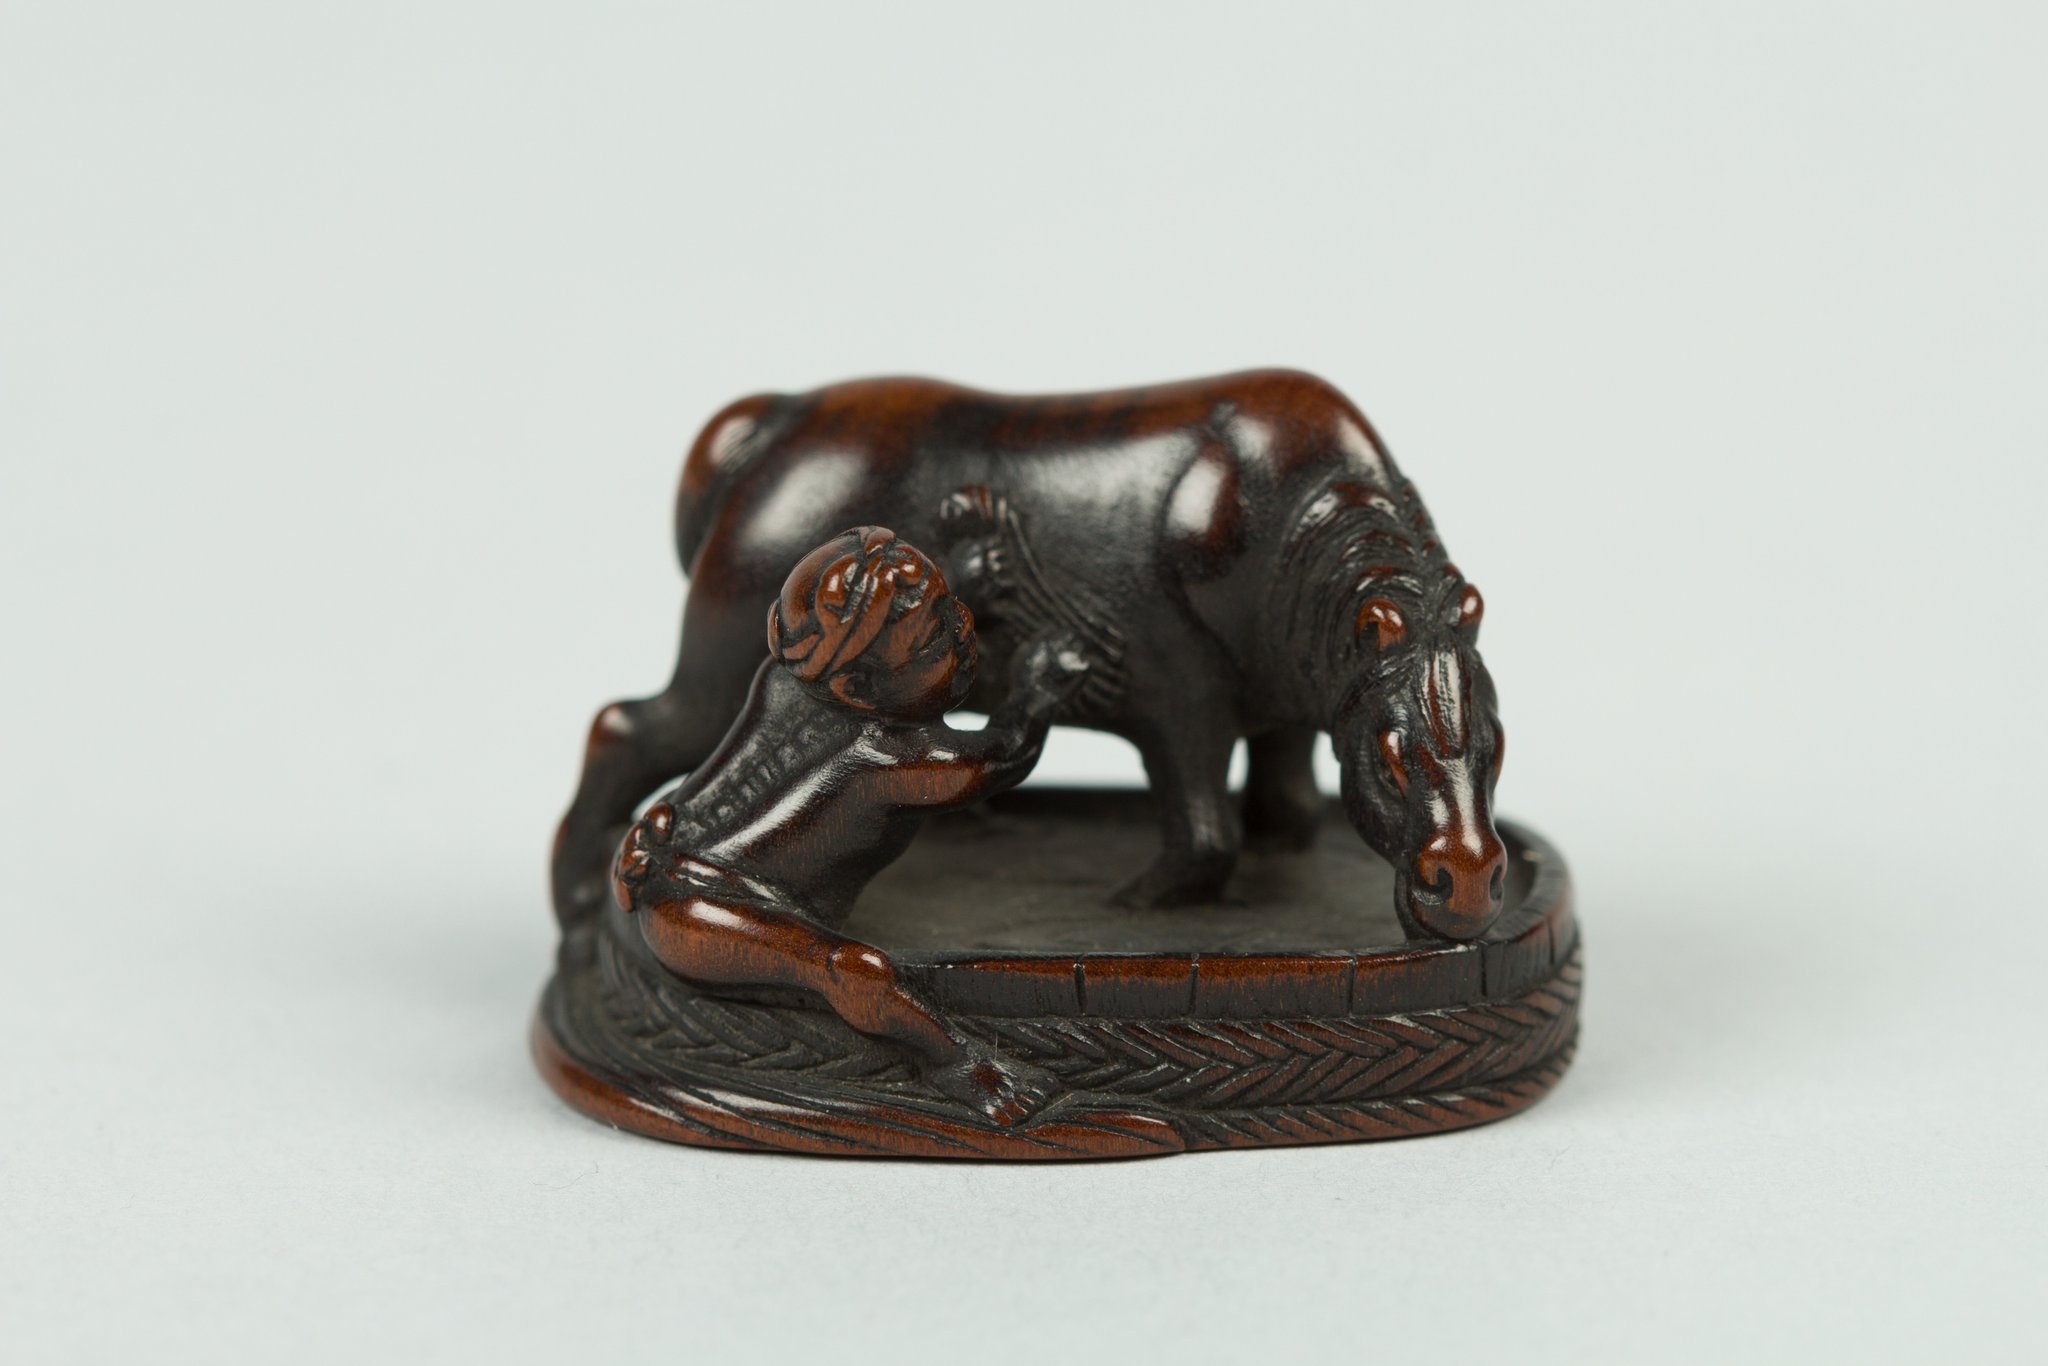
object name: netsuke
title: Netsuke of Boy Washing a Horse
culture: japanese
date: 1701-1800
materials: wood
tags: horses